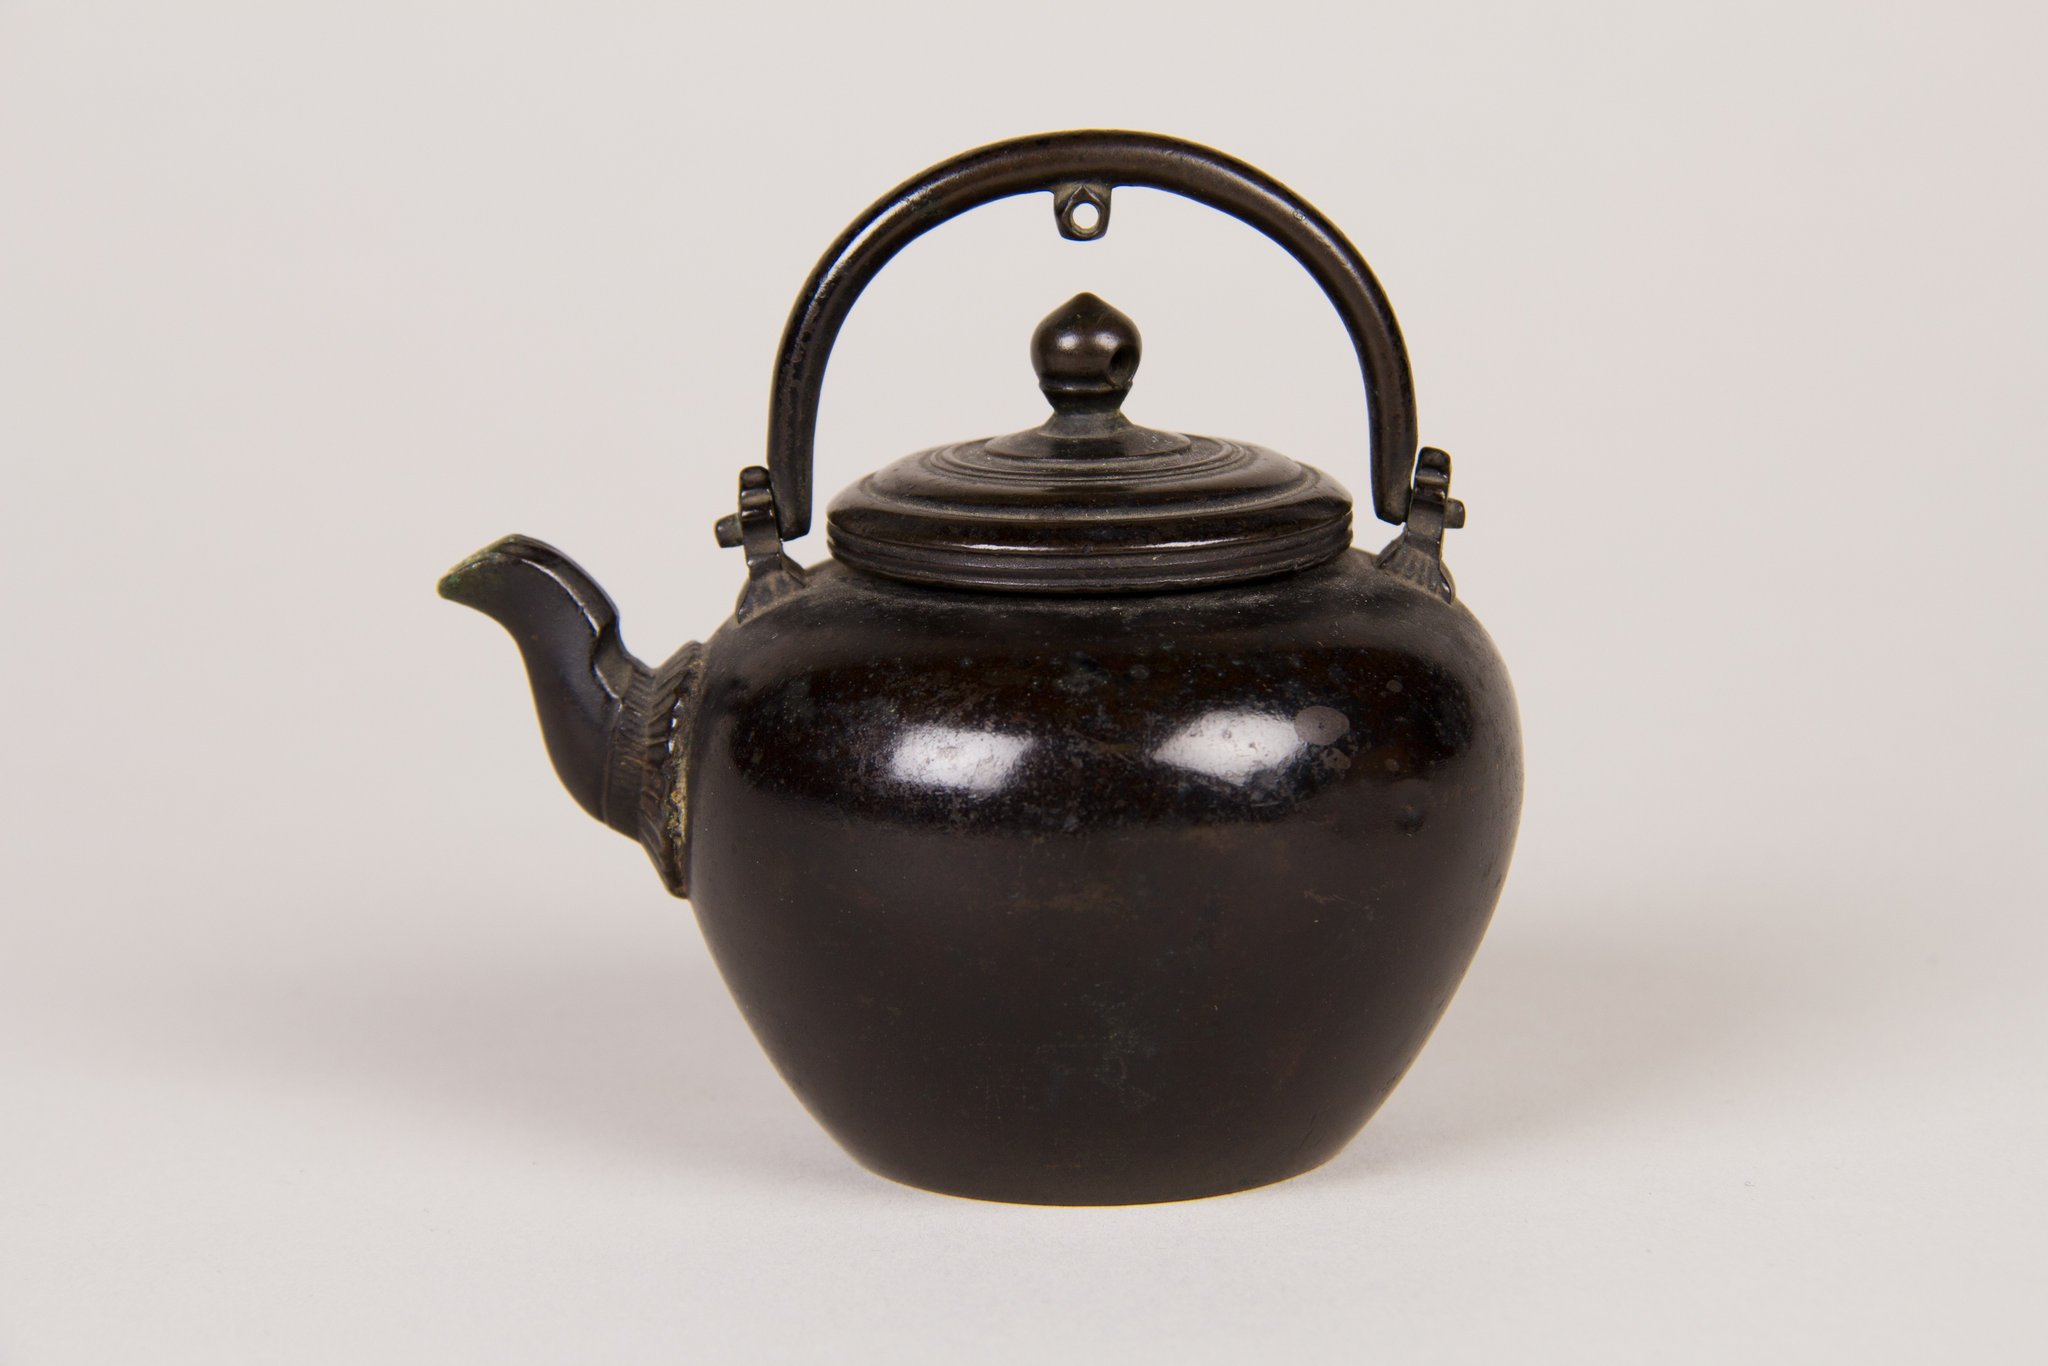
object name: ewer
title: Ritual Ewer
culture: japanese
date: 1201-1300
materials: gilt bronze